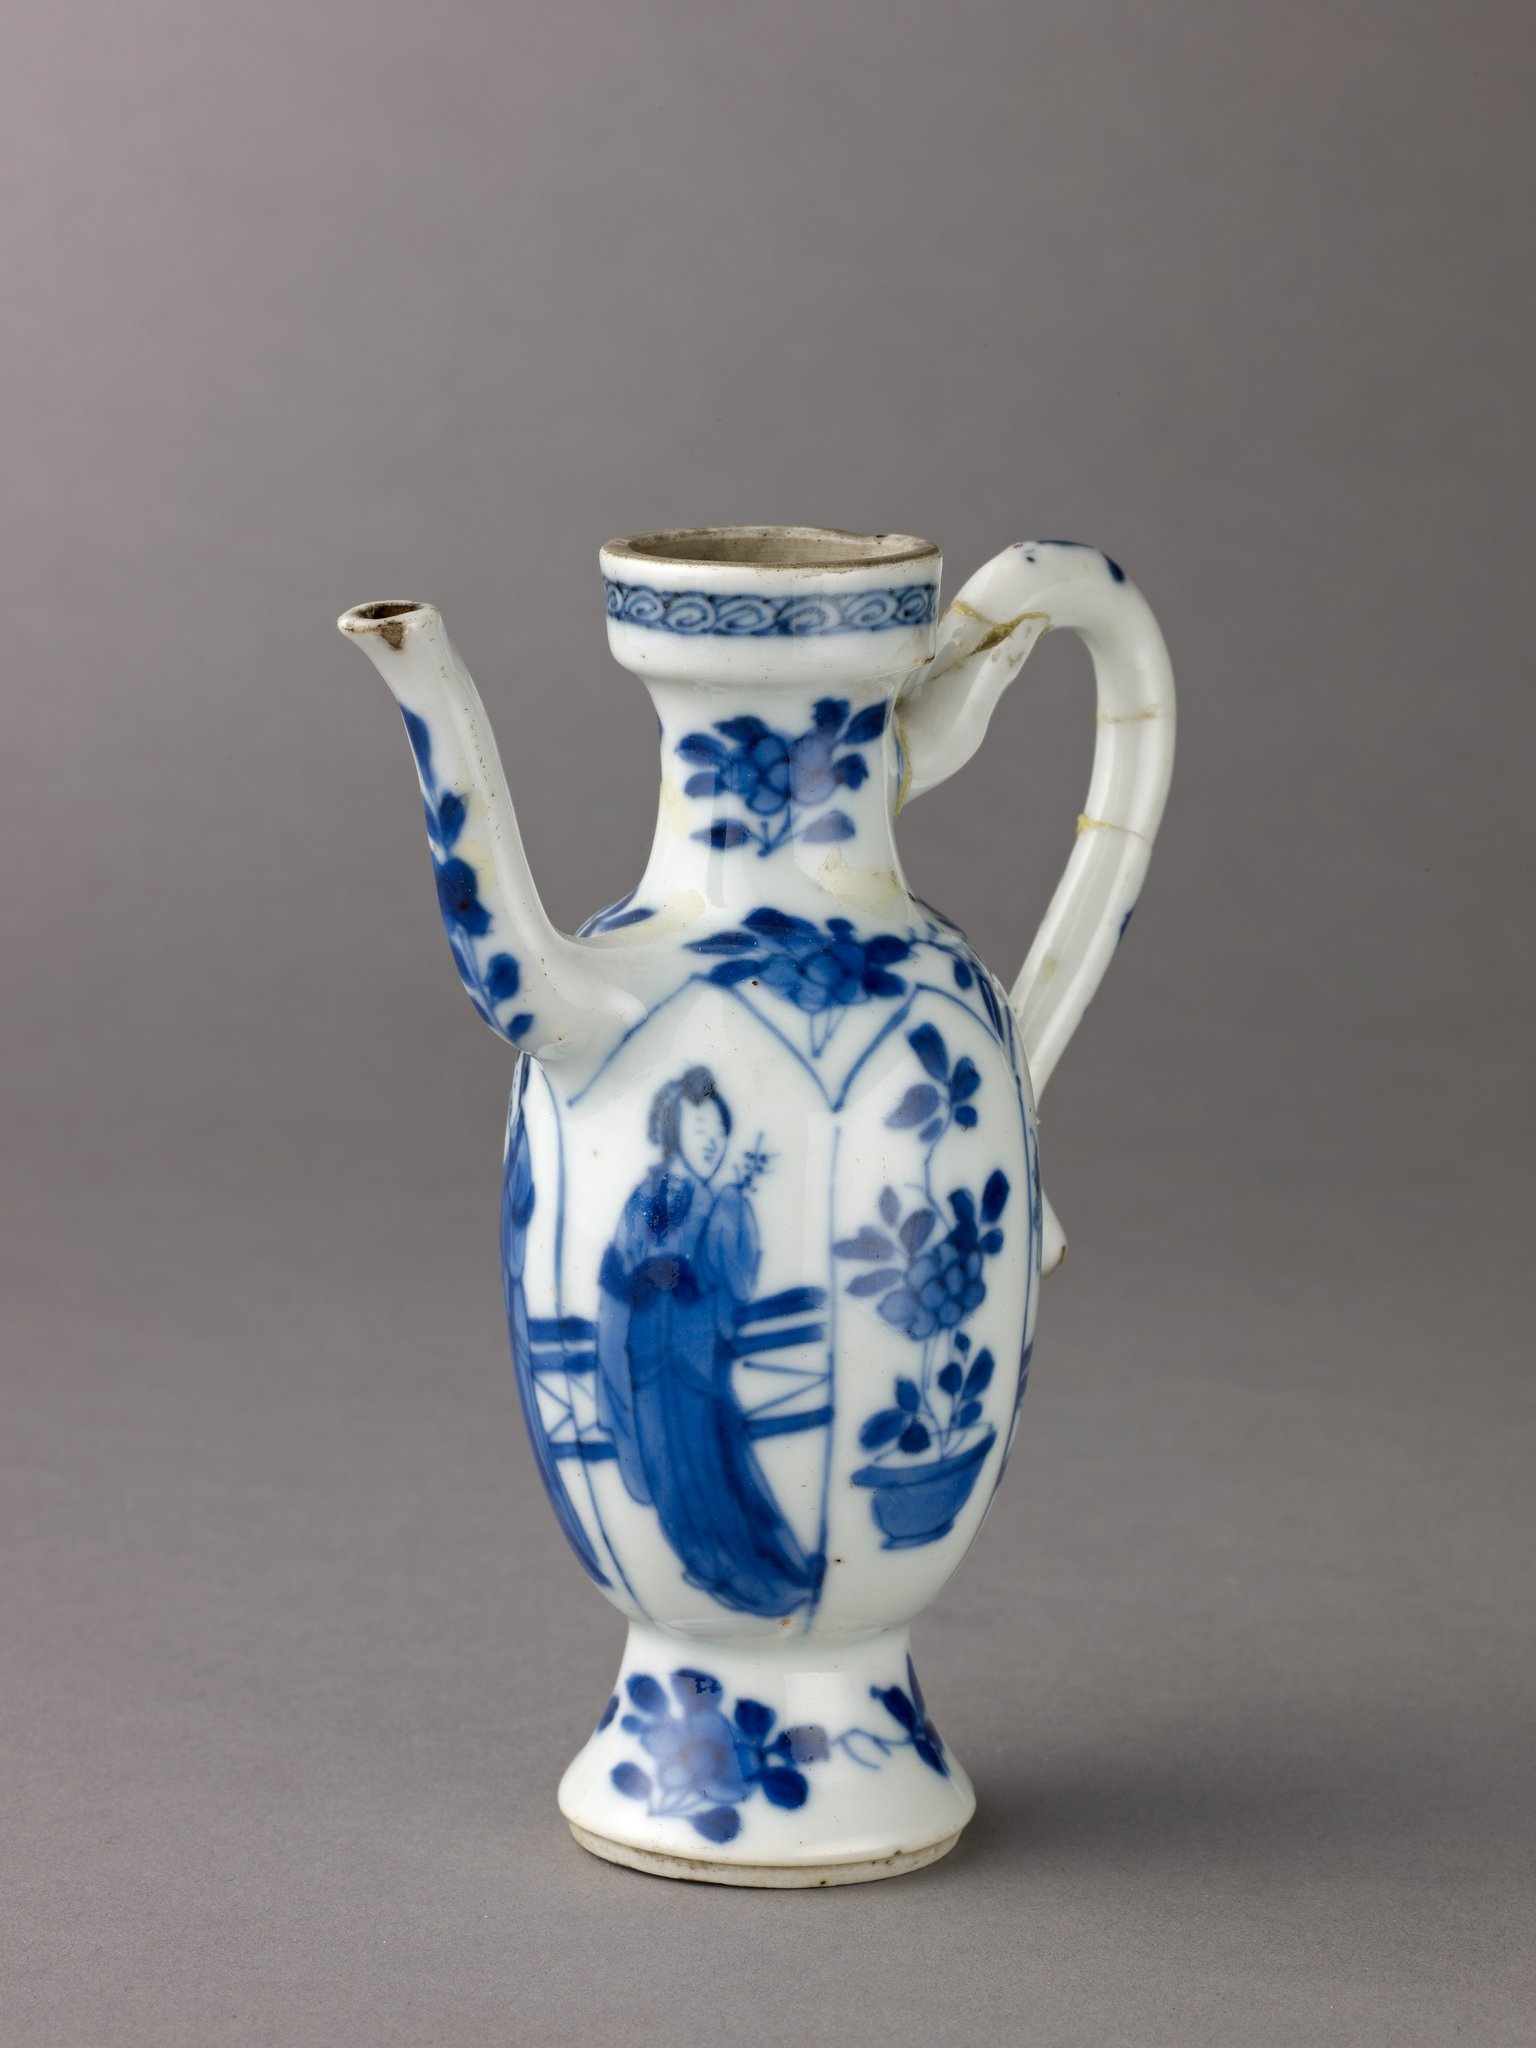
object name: ewer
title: Small ewer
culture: chinese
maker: chinese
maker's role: artist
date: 1662-1722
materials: porcelain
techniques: painting, underglaze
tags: women,flowers